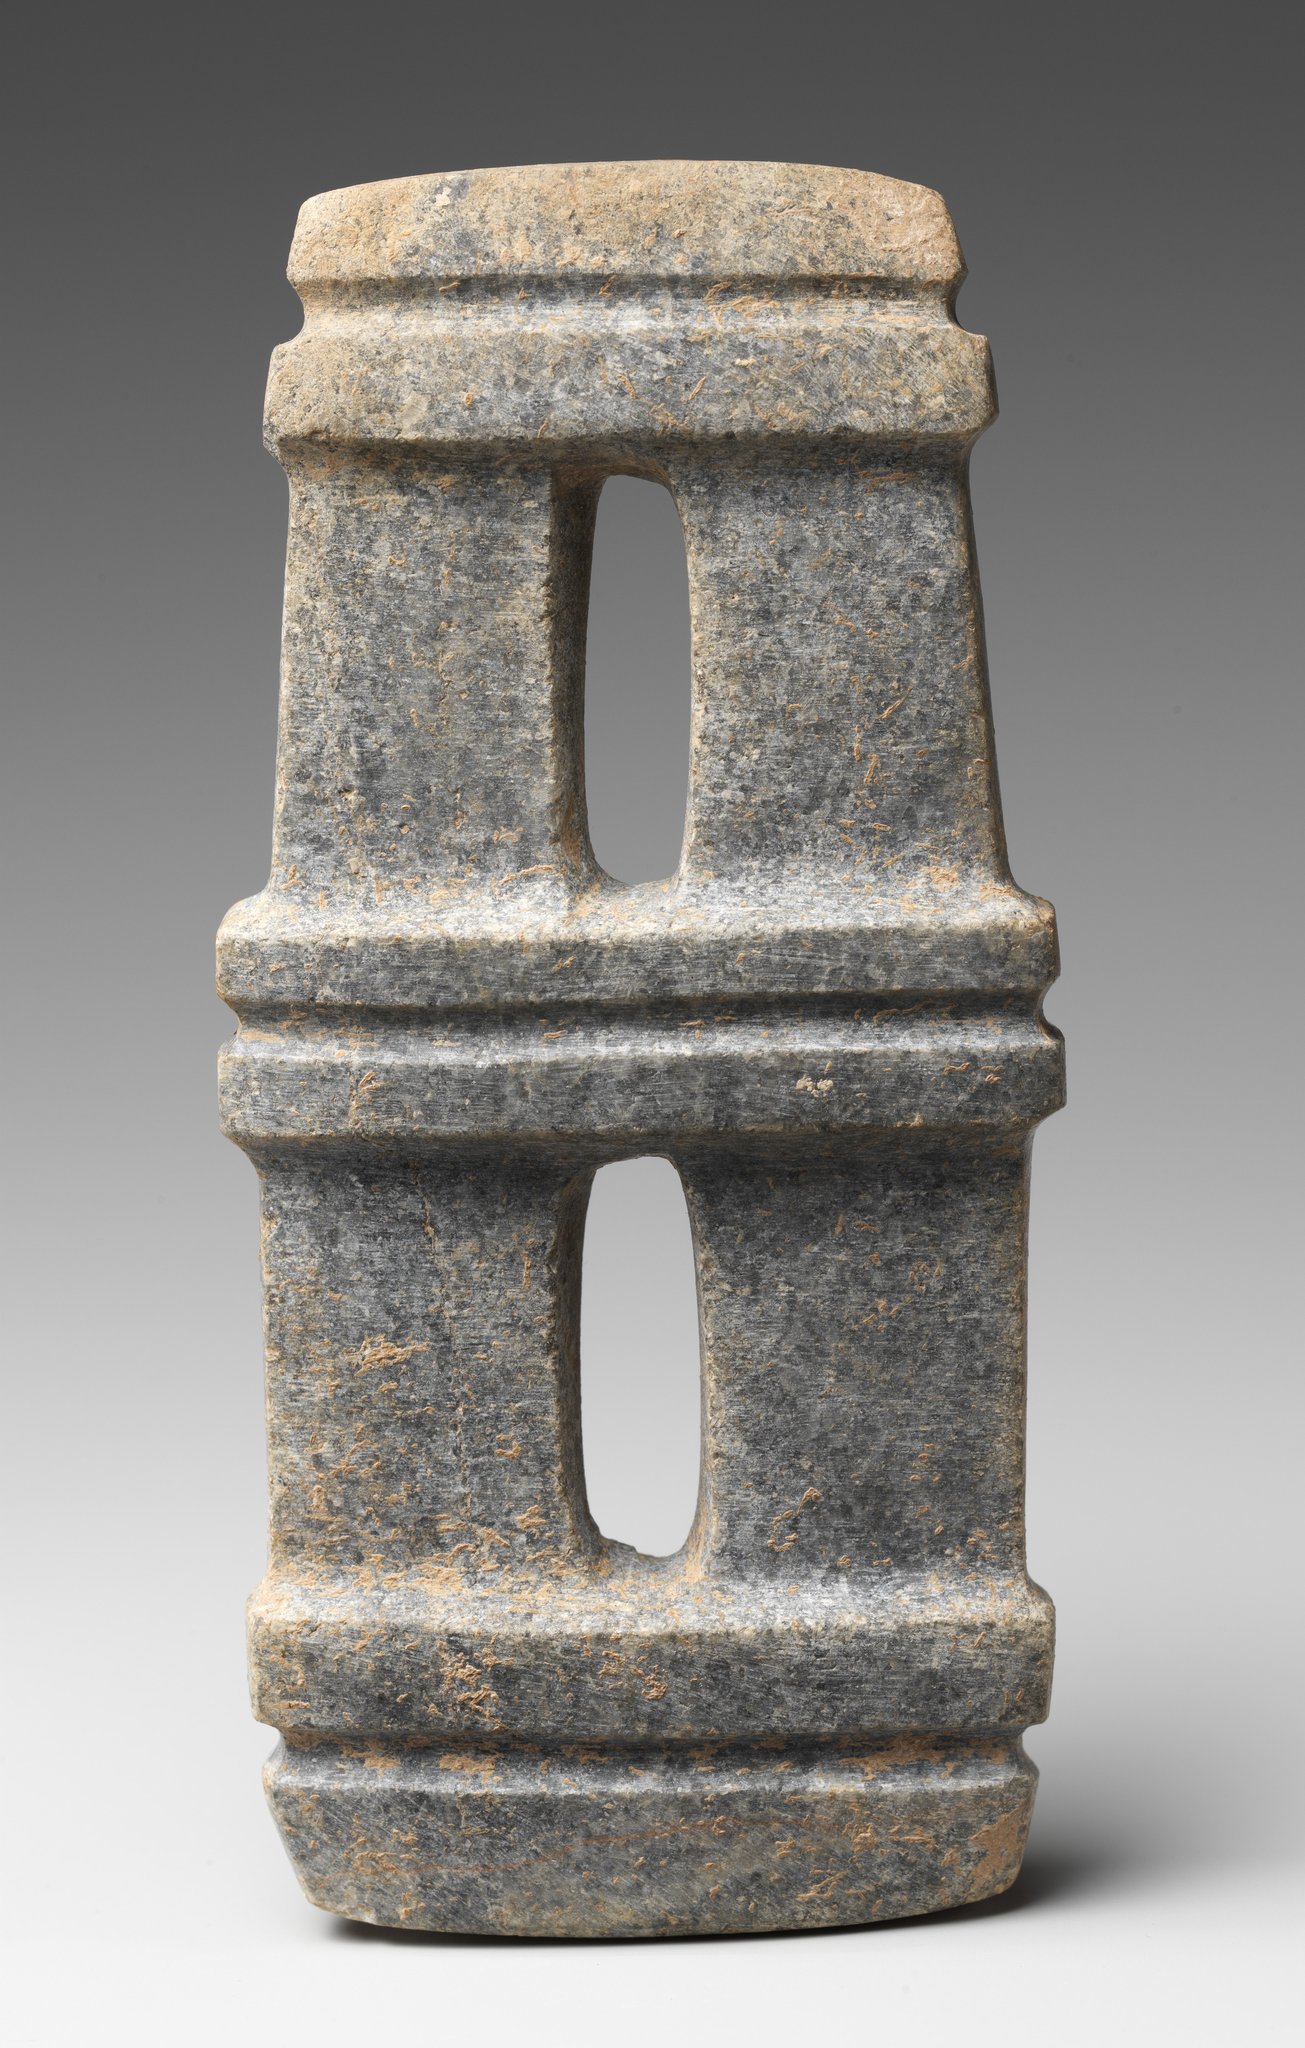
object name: architectural model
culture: mezcala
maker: mezcala artist(s)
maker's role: artist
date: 200 BCE-500 CE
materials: stone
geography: mexico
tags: temples